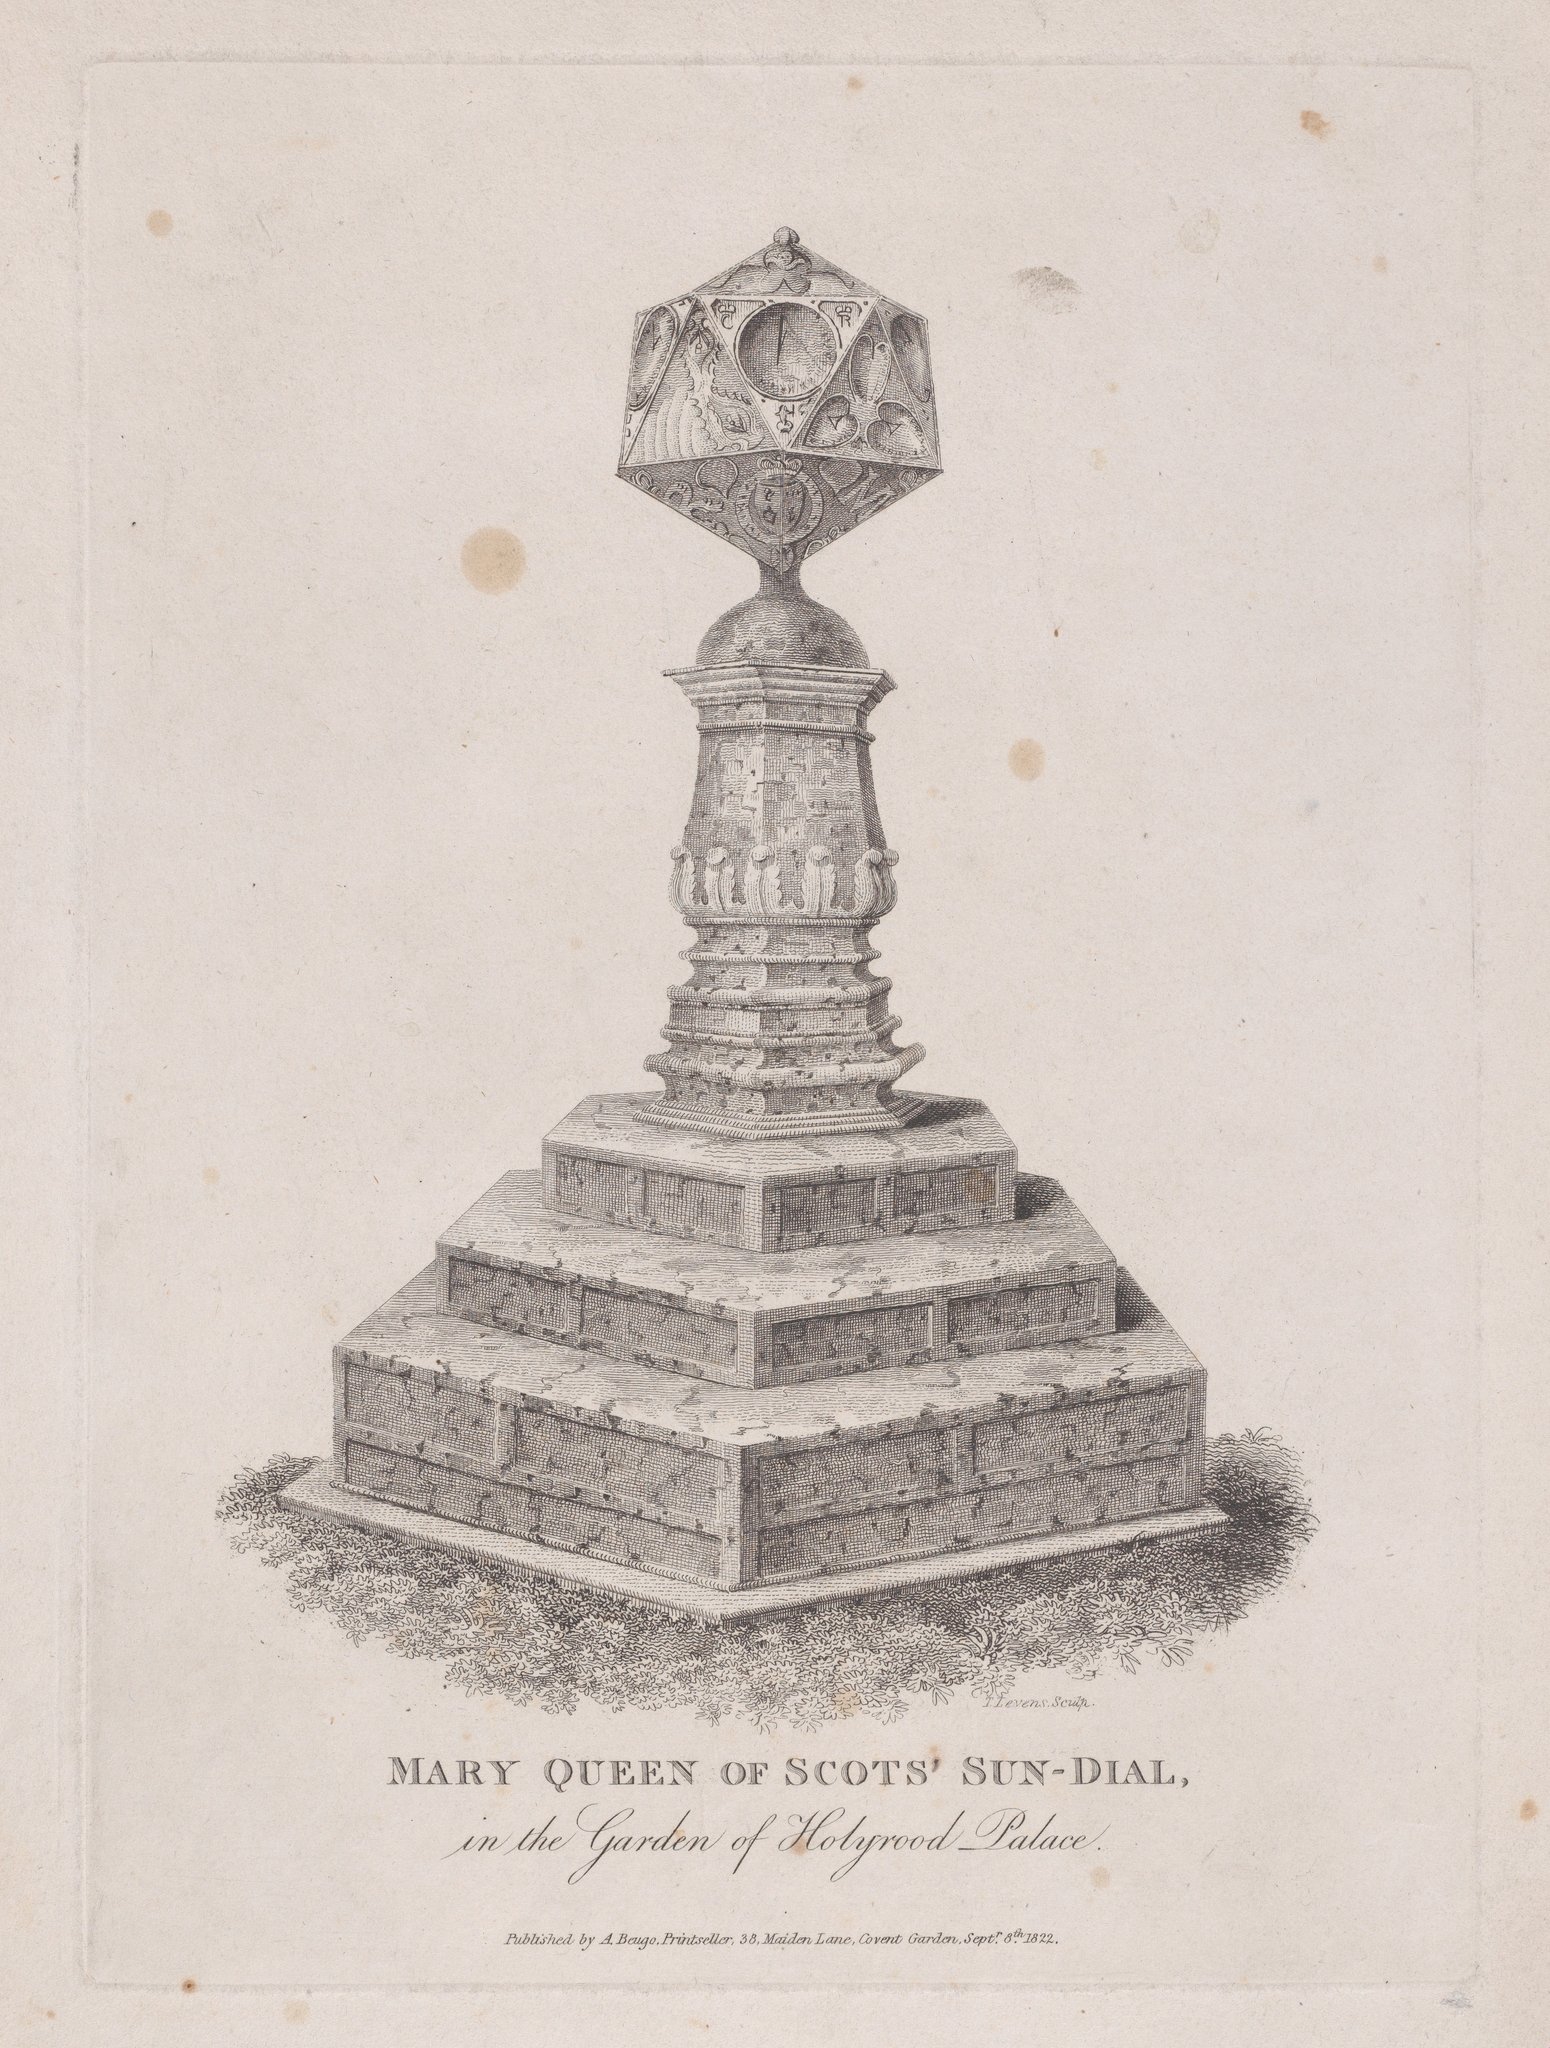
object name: print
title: Mary, Queen of Scots's Sundial, in the garden of Holyrood Palace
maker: t. levens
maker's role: artist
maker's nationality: british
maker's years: 1750-1875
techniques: etching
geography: england